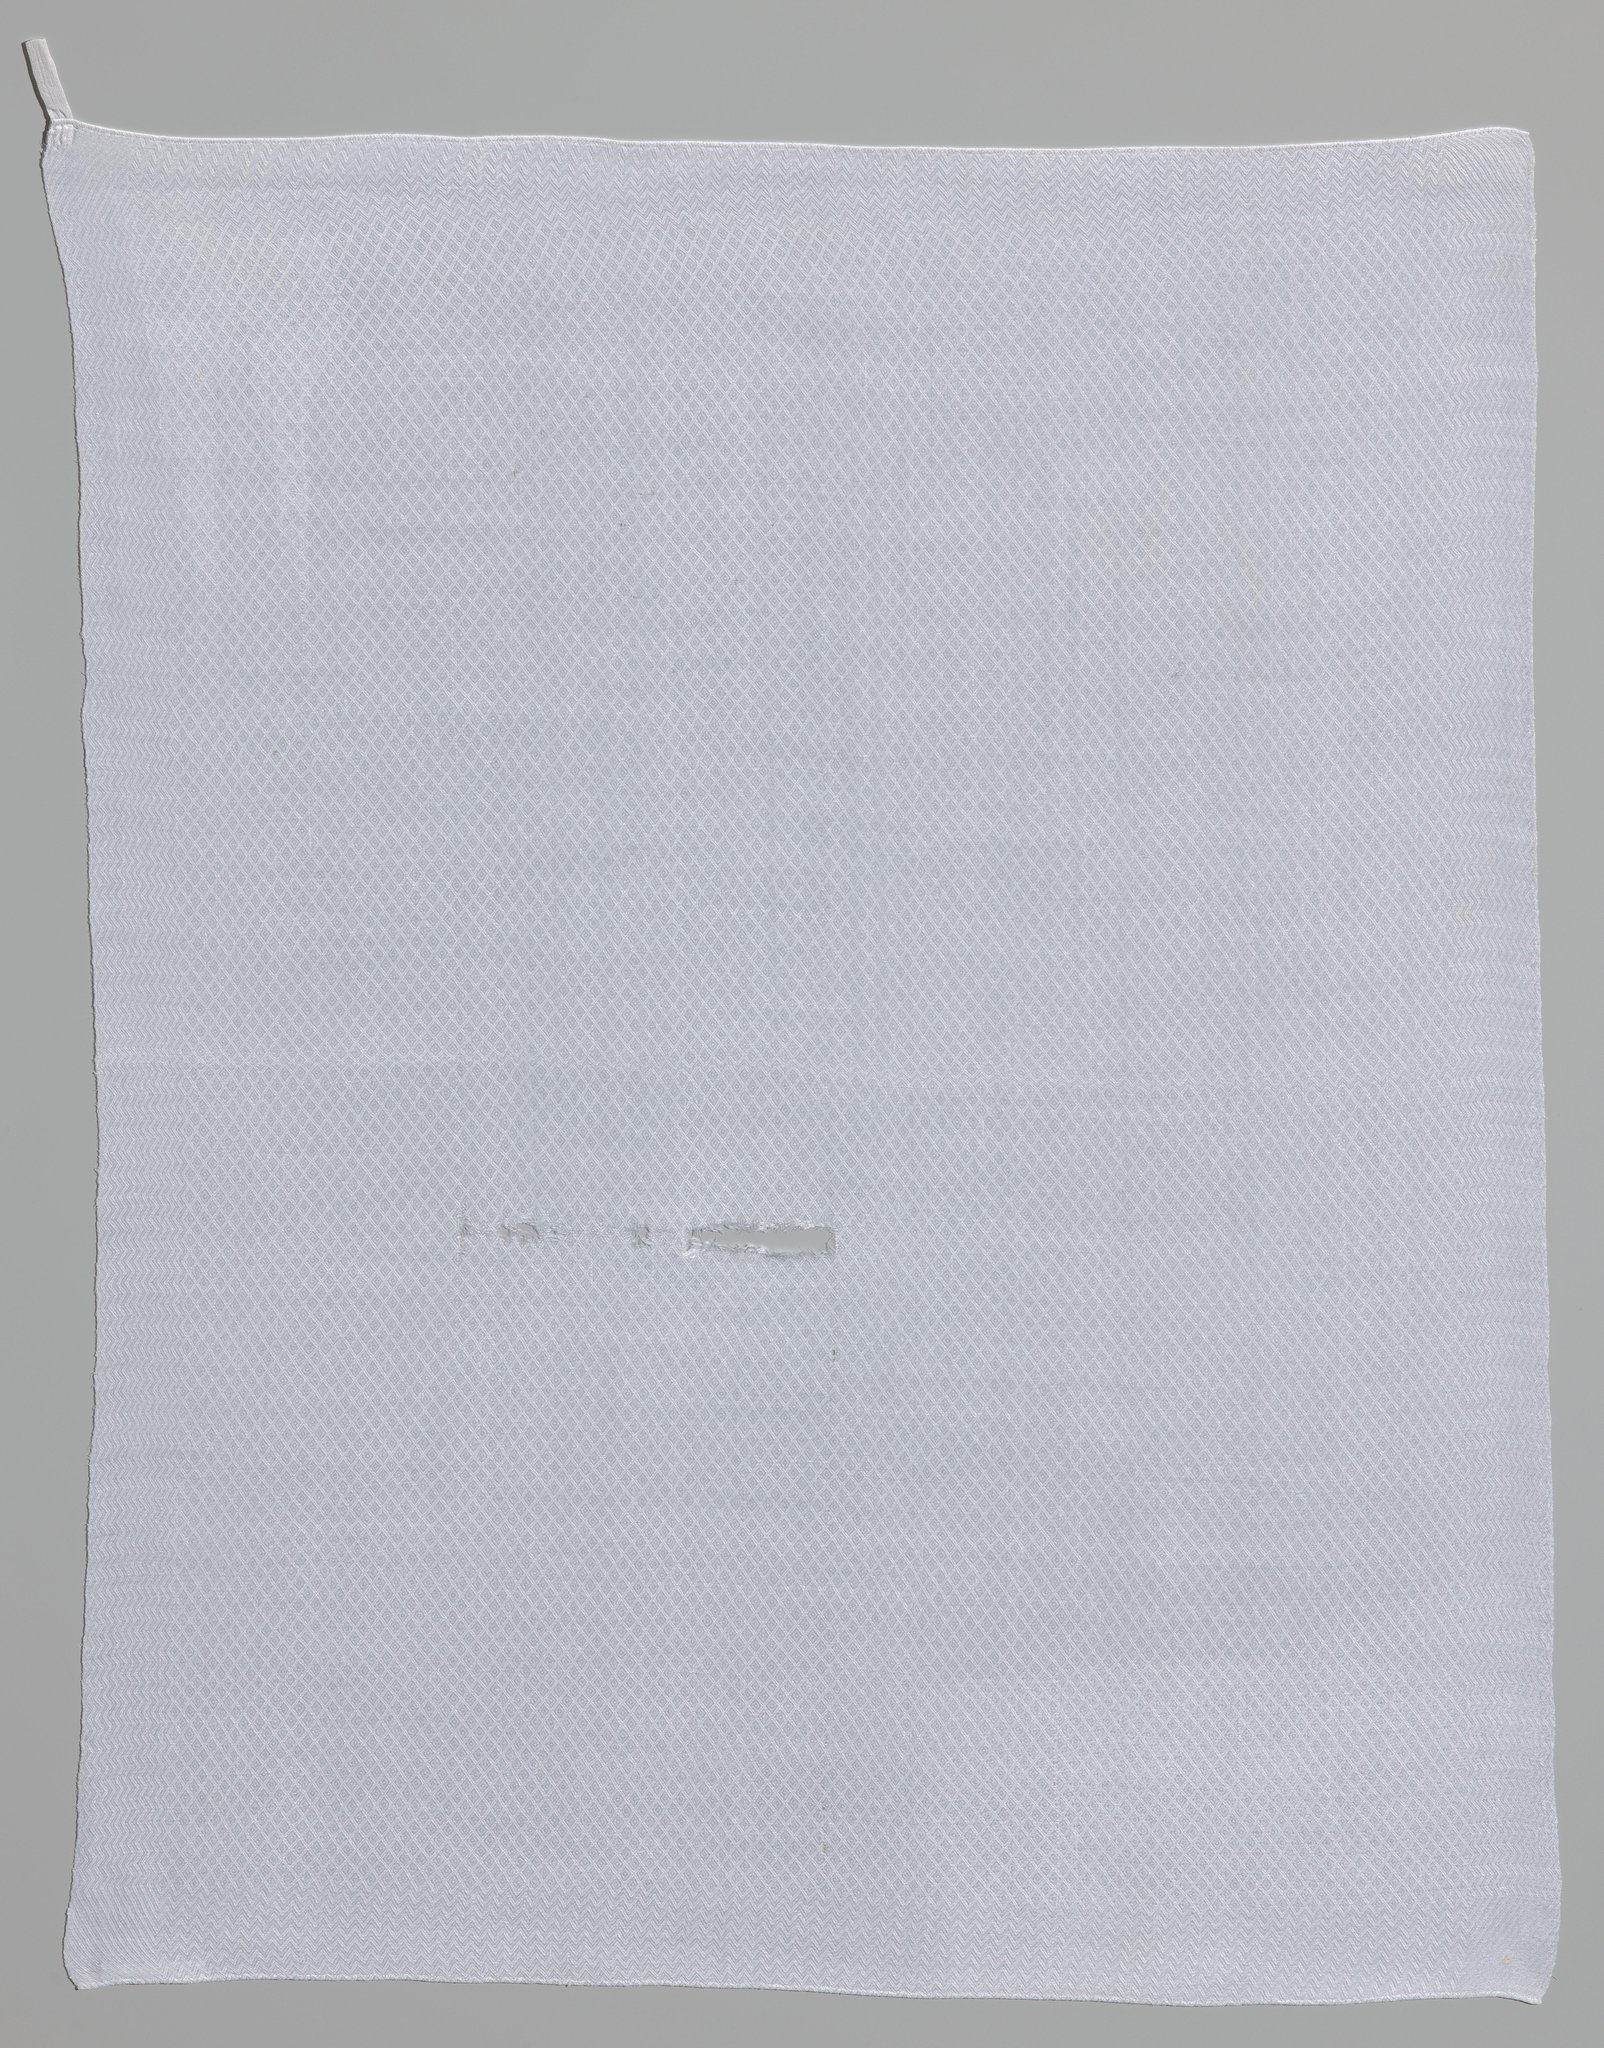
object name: towel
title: Handdoek van wit linnen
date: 1800-1899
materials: linen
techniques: peeled fabric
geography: netherlands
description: Wit linnen handdoek met een pellen patroon z.g. 'gansoog' en randen rondom, merk HK WH 2oonl.